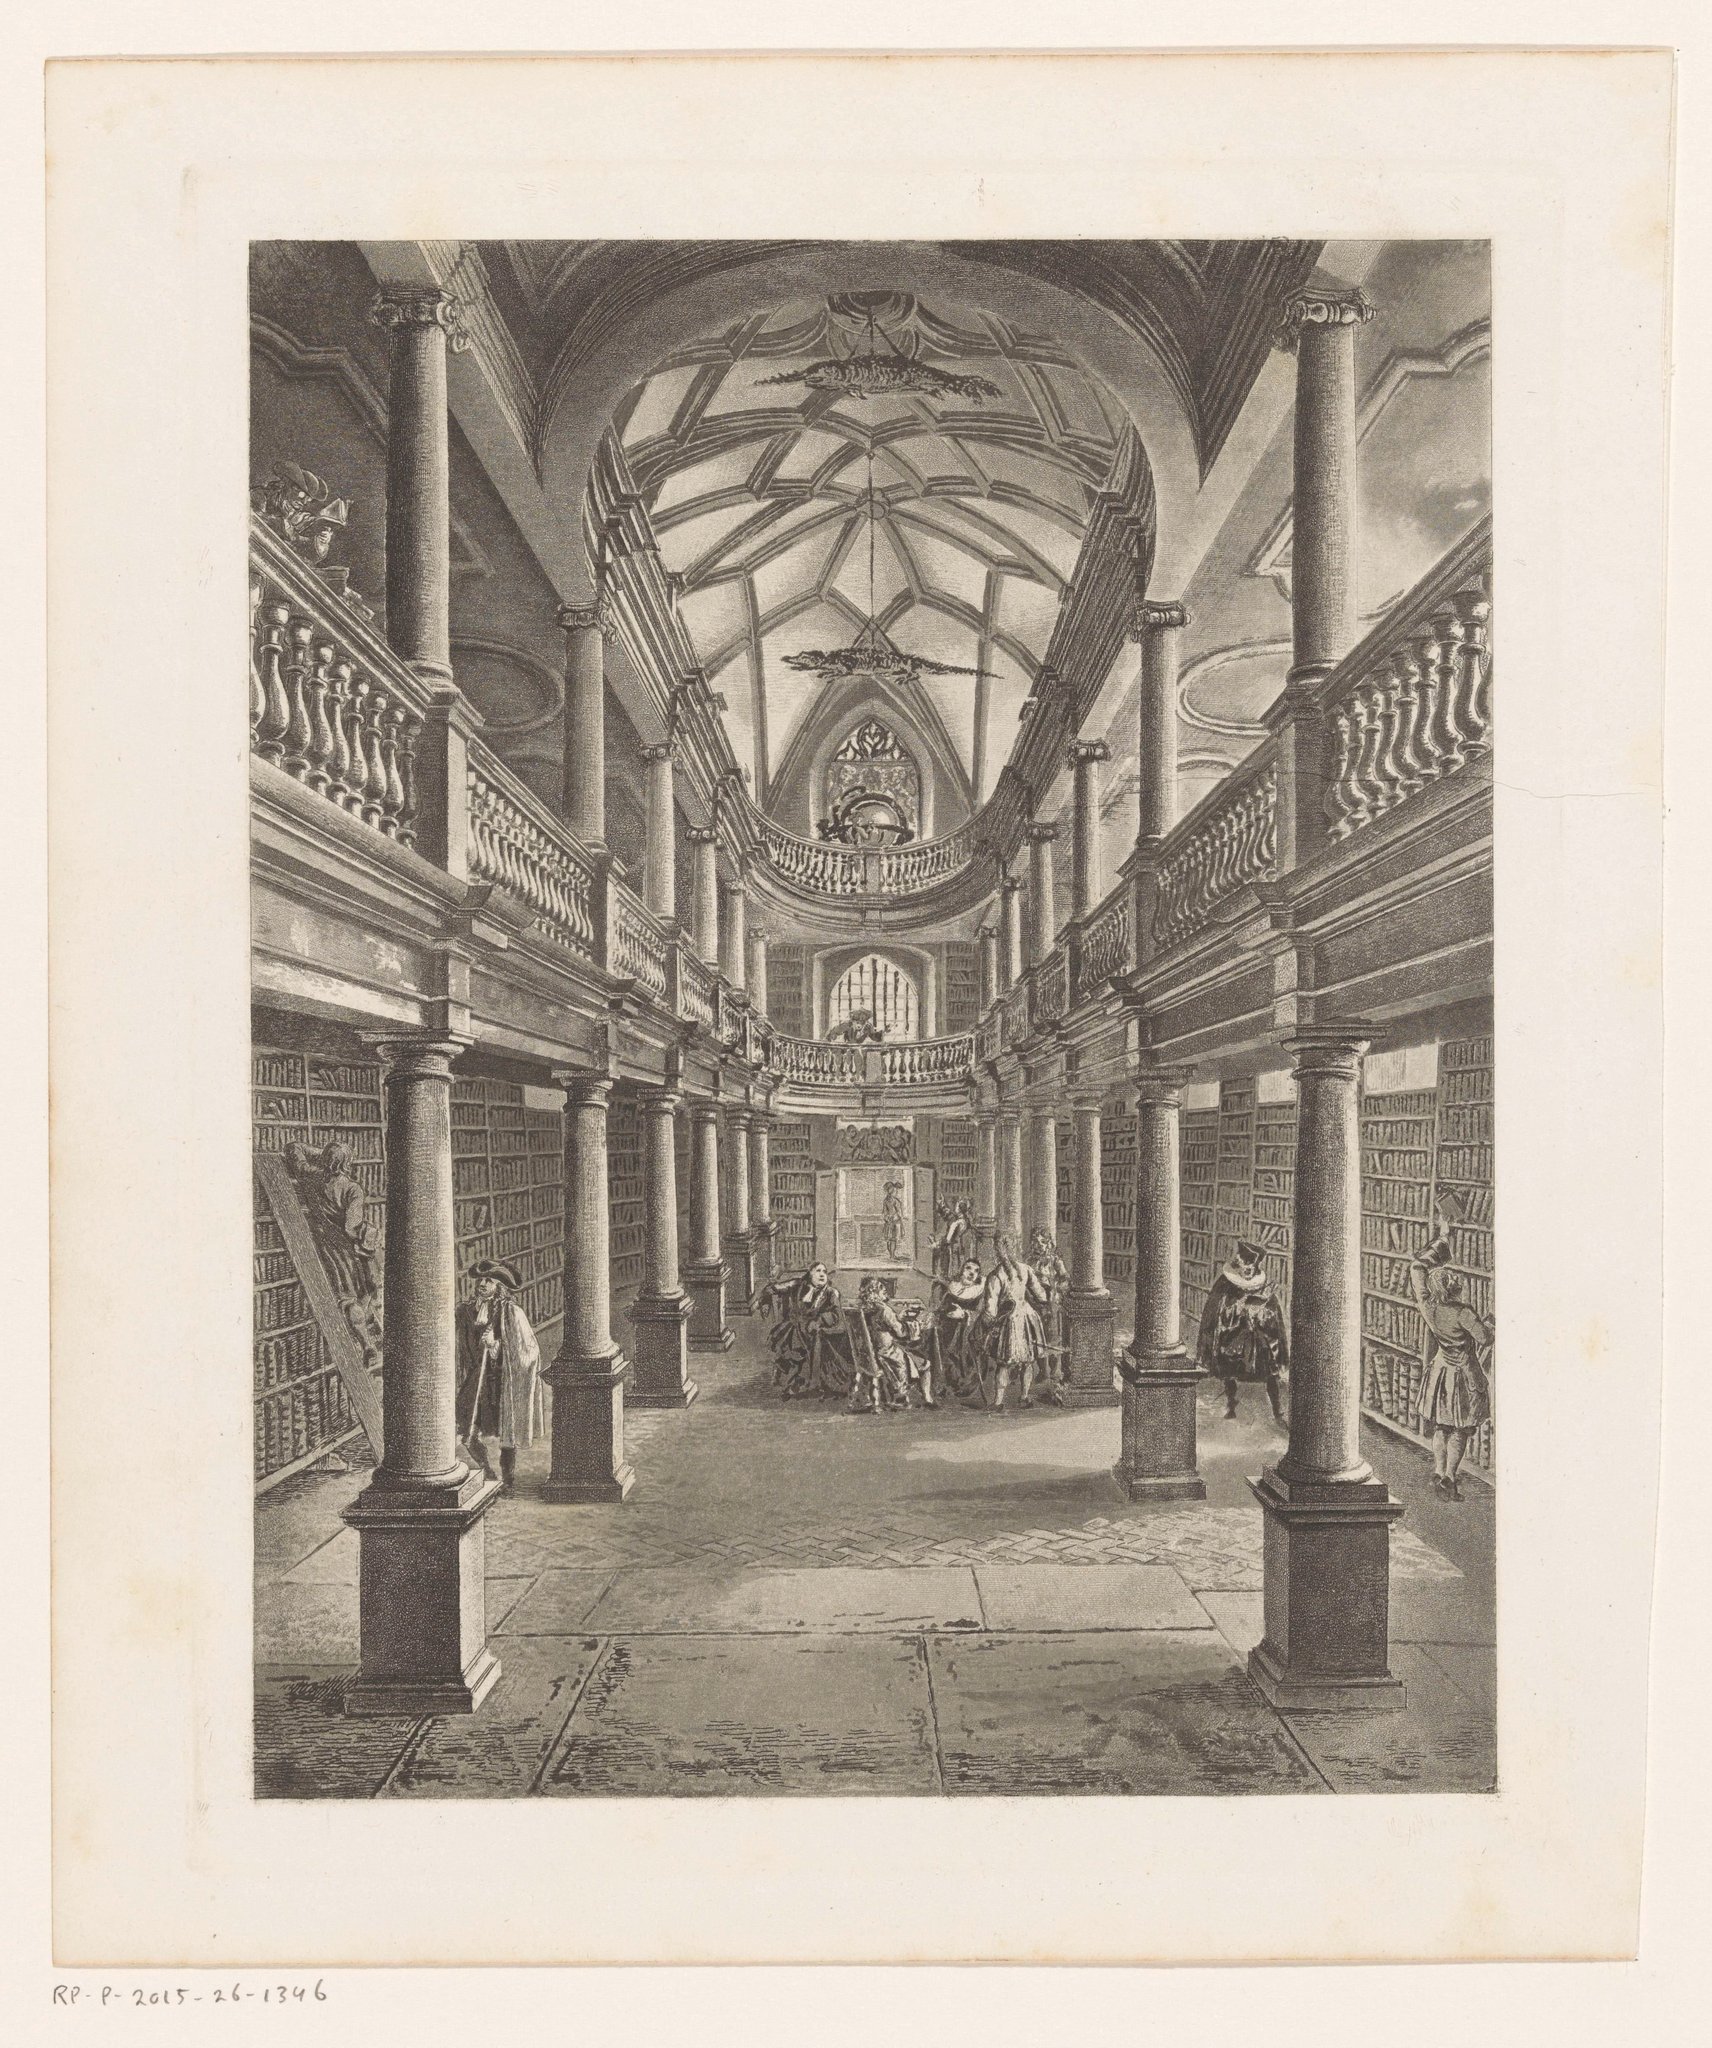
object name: book illustration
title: Interieur van de Wasserkirche te Zürich, 1715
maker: franz hegi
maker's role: draughtsman, painter, print maker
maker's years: 1774-1850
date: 1848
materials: paper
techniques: aquatint, etching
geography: zurich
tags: crocodiles, globe, public library, bony fishes: sword-fish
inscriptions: collector's mark: Lugt 2228, collector's mark: Lugt 4780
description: Een eerder gebouwde verdieping is verwijderd en er zijn balustrades aangelegd. De benedenverdieping is in gebruik als bibliotheek. Aan het plafond hangen een krokodil en een zaagvis. Op de bovenste verdieping is een globe te zien.